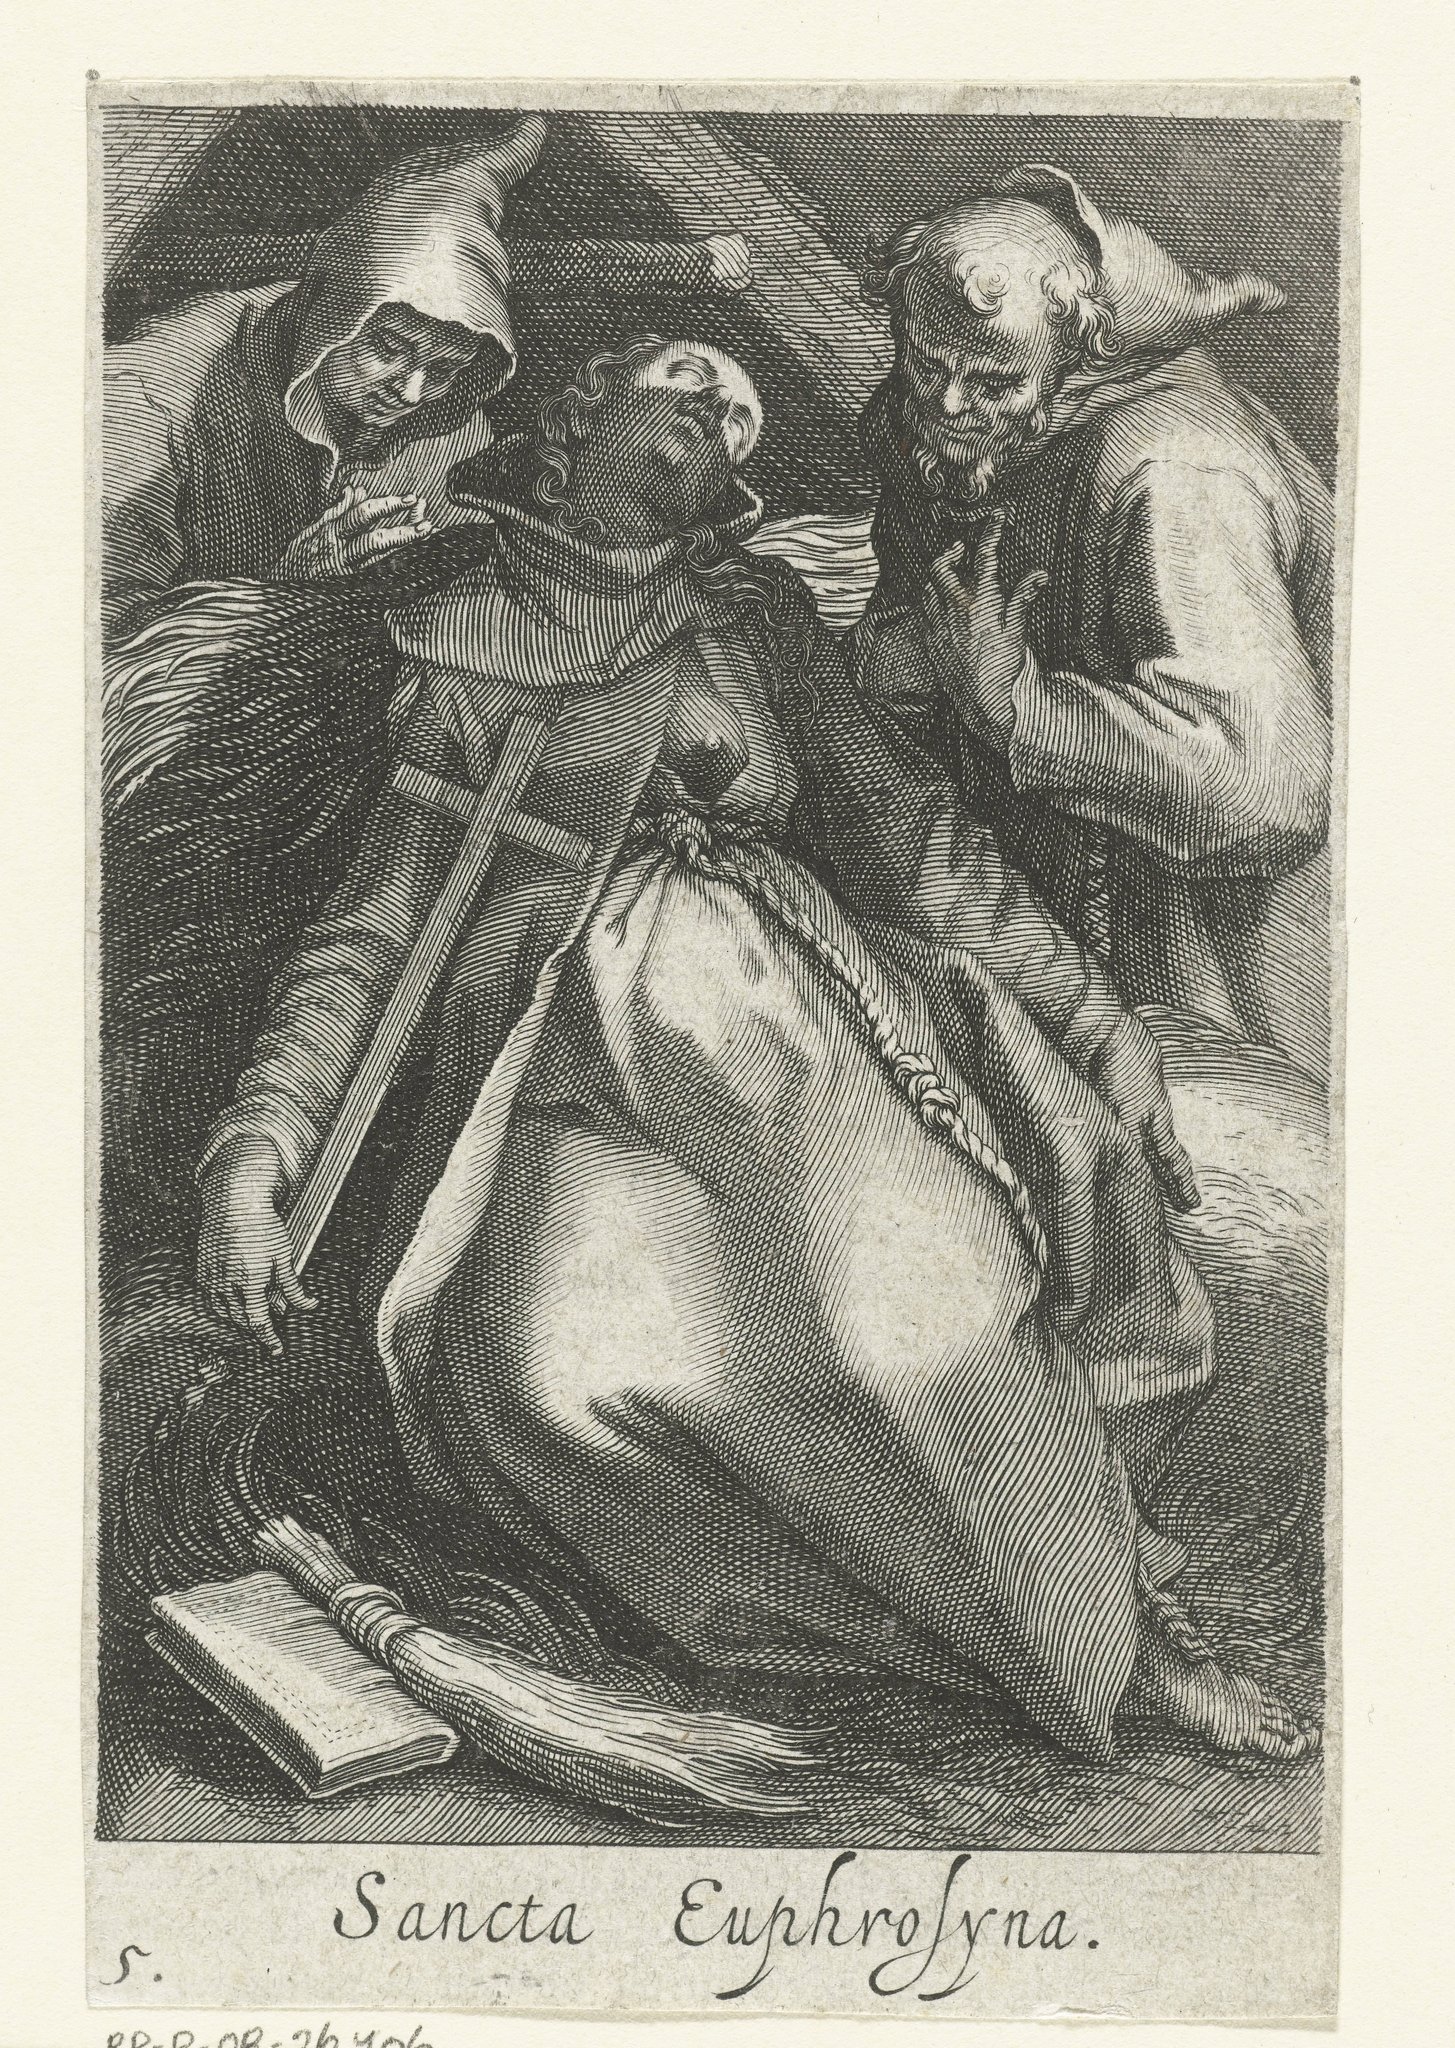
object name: book illustration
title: Sancta Euphrosyna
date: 1590-1612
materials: paper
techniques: engraving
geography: low countries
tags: anchorite, hermit, female saints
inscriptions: collector's mark: Lugt 2228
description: Prent uit: Sacra Eremus Ascetriarum, Hendrik Aertssen, Antwerpen 1619. Prent uit de serie van vijfentwintig kluizenaressen in deze uitgave. In 1612 verscheen de ongebonden editie maar op basis van de gewijzigde opschriften en samenstelling van de serie kluizenaars wordt aangenomen dat de prenten van de uitgave 1619 ook in 1612 of iets daarvoor gedrukt werden. De serie kluizenaressen bleef vrijwel ongewijzigd in de ongebonden uitgave van 1612, dit compliceert de datering van de losse bladen in de collectie van het RMA, zie Roethlisberger 1993, p. 171-175. Door de aanwezigheid van Franse tekst op het verso kunnen we vaststellen dat dit blad afkomstig is uit de Antwerpse uitgave van 1619.